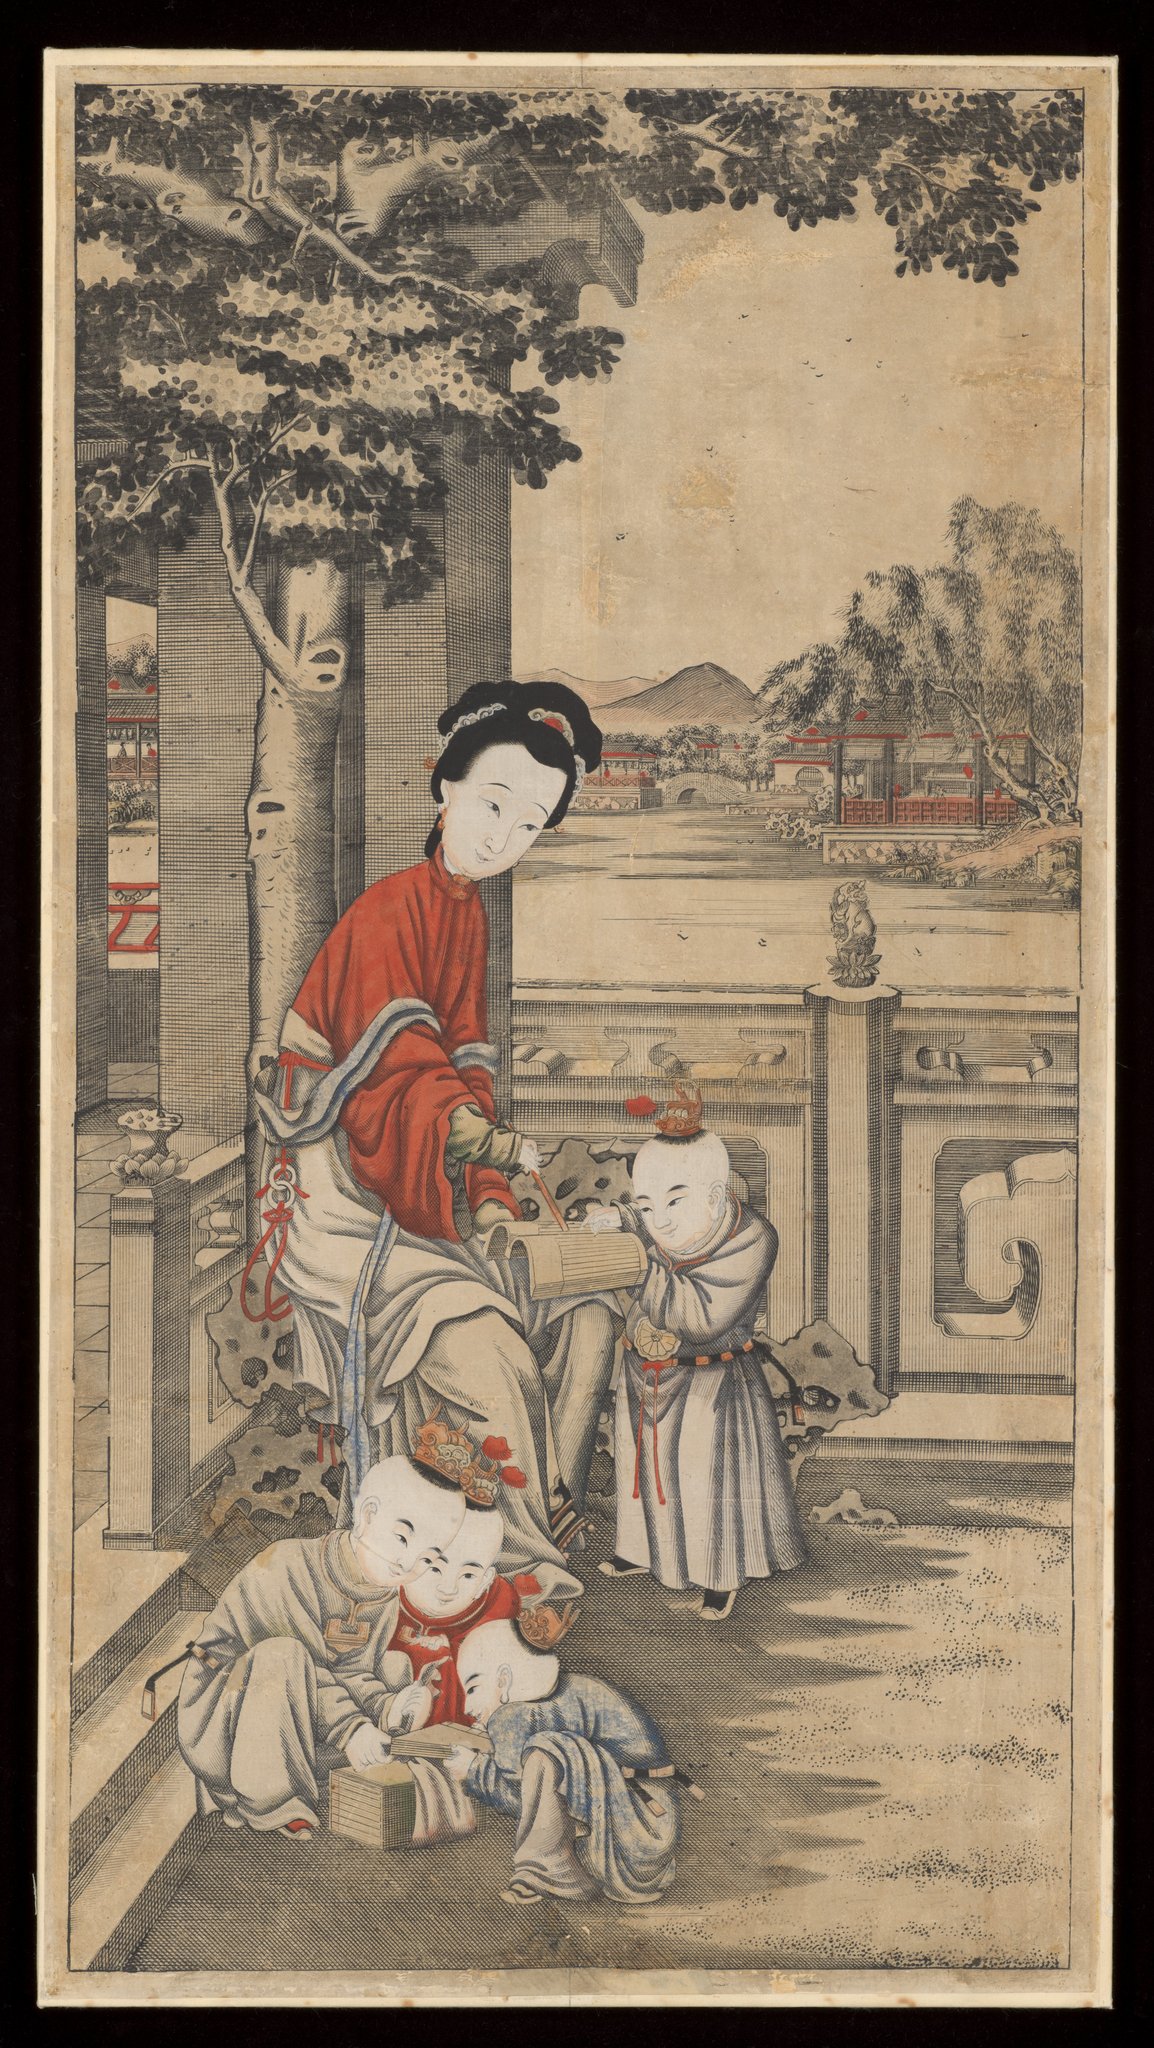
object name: print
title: Woman teaching children to read and write calligraphy, from four-print set “Women teaching children the four accomplishments”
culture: chinese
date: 1736-1795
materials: ink, paper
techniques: hand coloring, woodblock print